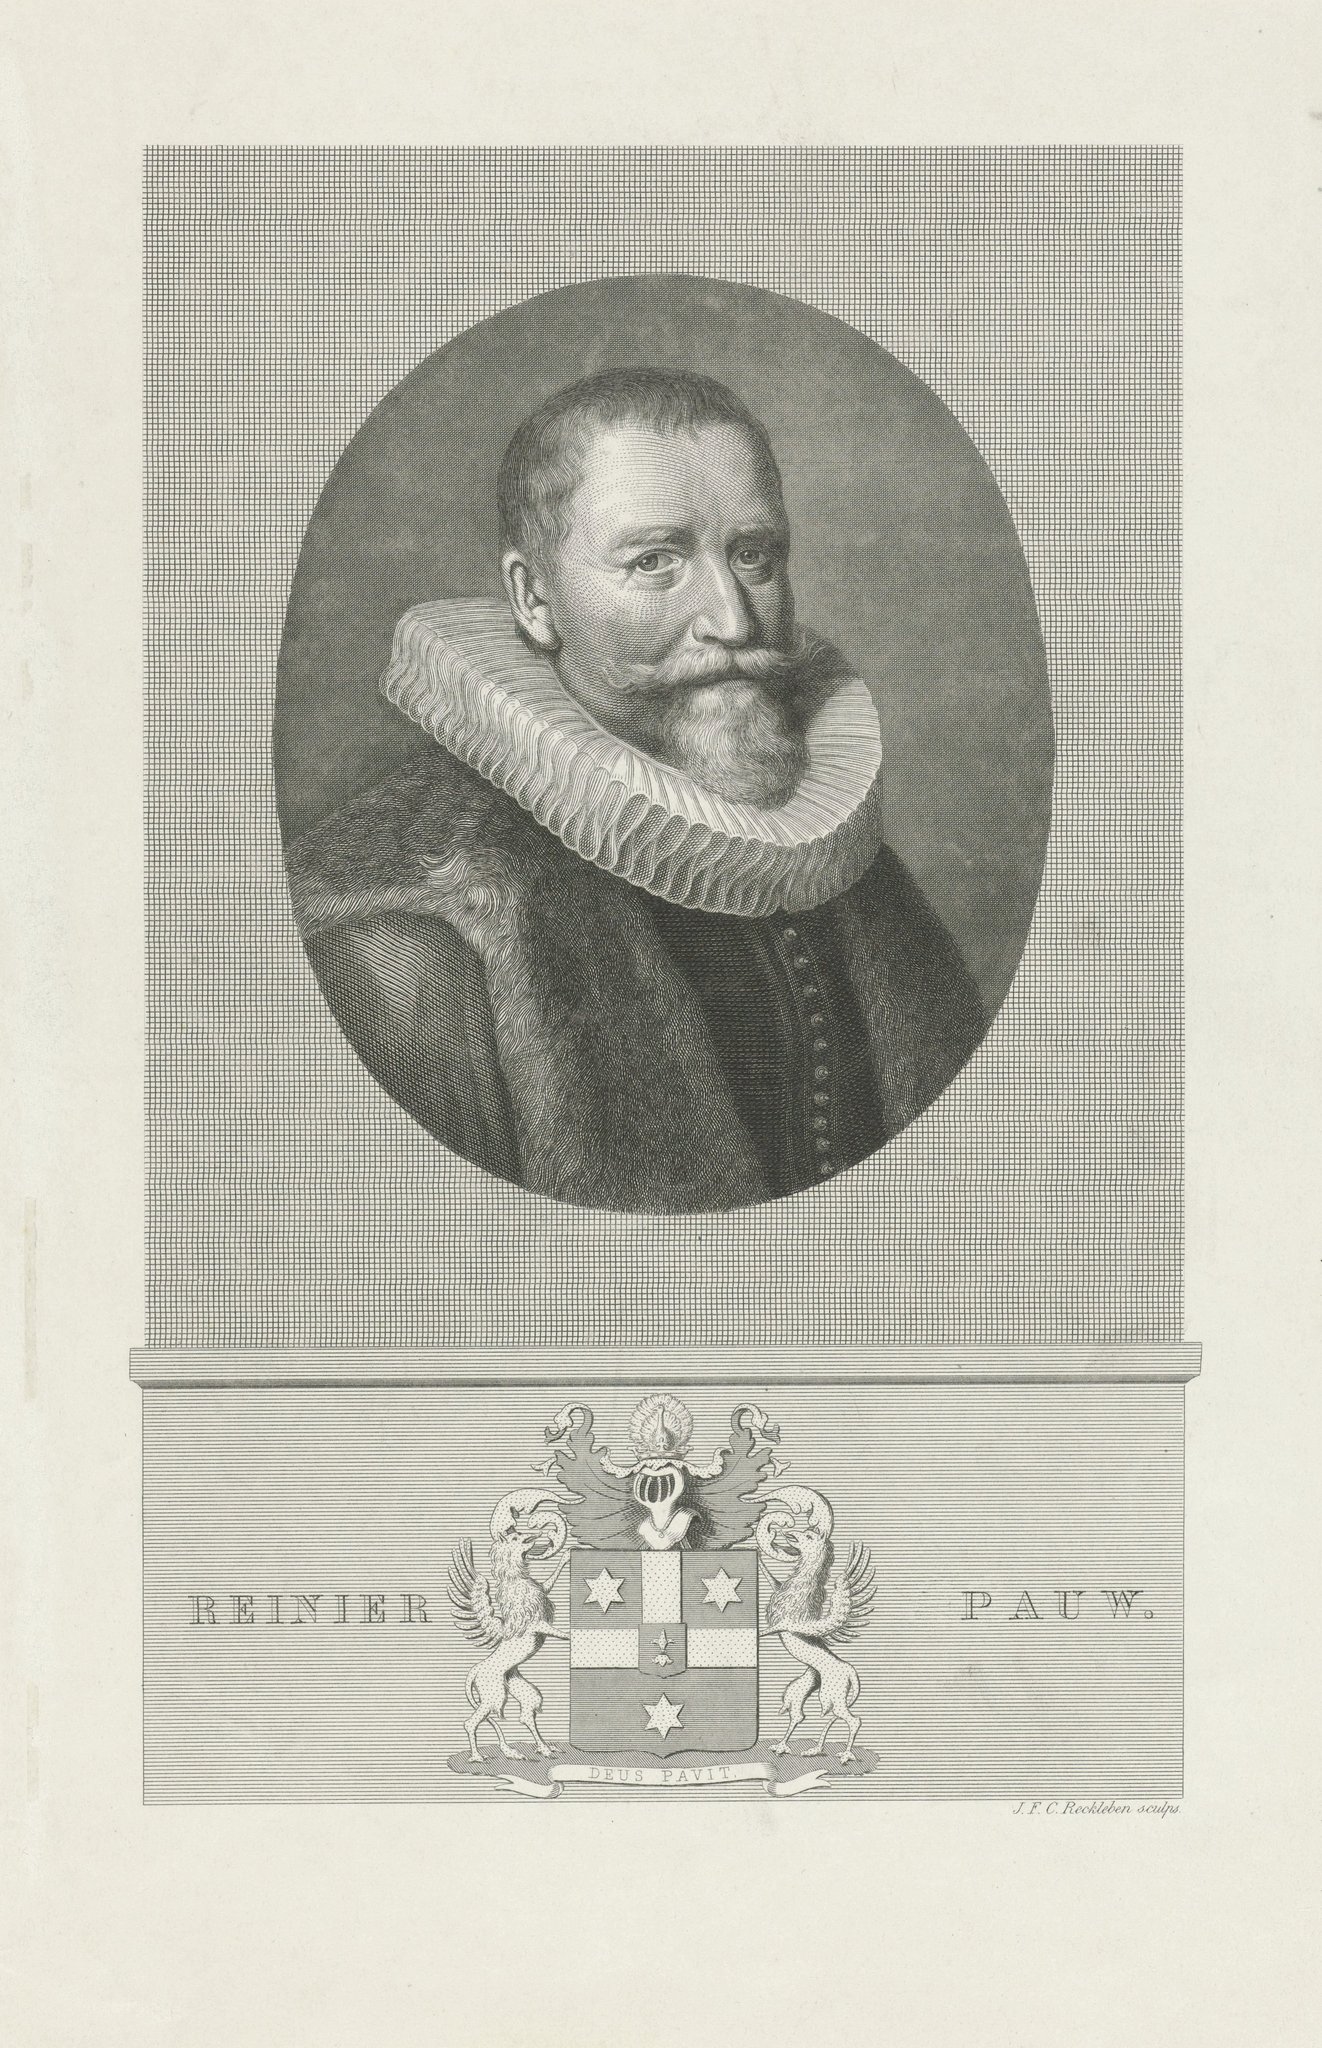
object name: print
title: Portret van Reinier Adriaensz. Pauw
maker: jan frederik christiaan reckleben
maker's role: print maker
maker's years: 1819-1879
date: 1858-1860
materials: paper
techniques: engraving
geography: amsterdam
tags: amsterdam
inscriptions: collector's mark: Lugt 2228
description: Illustratie in: Arend, Johannes Pieter. Algemeene geschiedenis des vaderlands van de vroegste tijden tot op heden. 5 delen, Amsterdam: Schleijer, J.F. 1840-1884, dl. 3.3, p. 87.